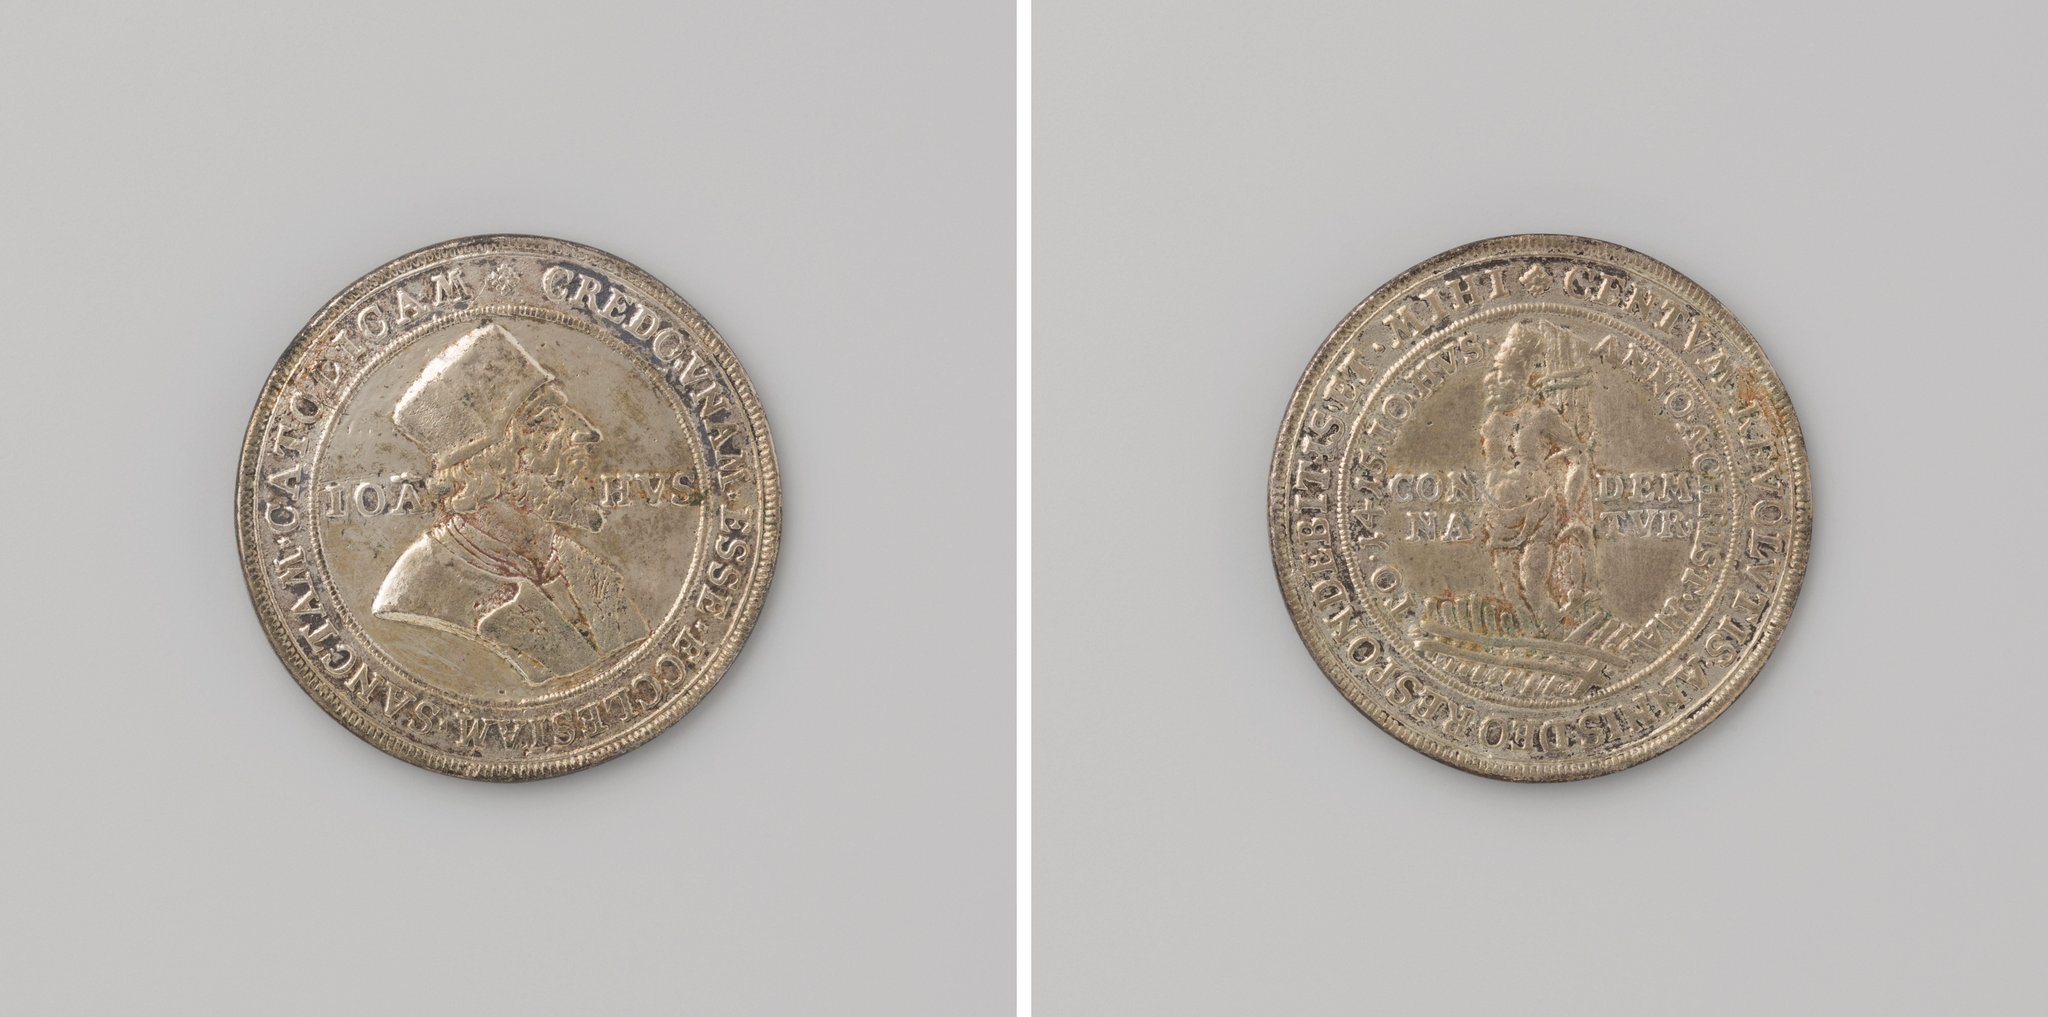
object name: history medal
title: Verbranding van Johannes Hus in 1415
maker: Anonymous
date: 1515-1715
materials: silver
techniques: striking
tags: violent death by burning at the stake; pyre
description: Zilveren penning. Voorzijde: borststuk man (Jan Hus) tussen opschrift, binnen omschrift. Keerzijde: Hus met kroon vastgebonden op brandstapel tussen opschrift, binnen tweeregelig omschrift